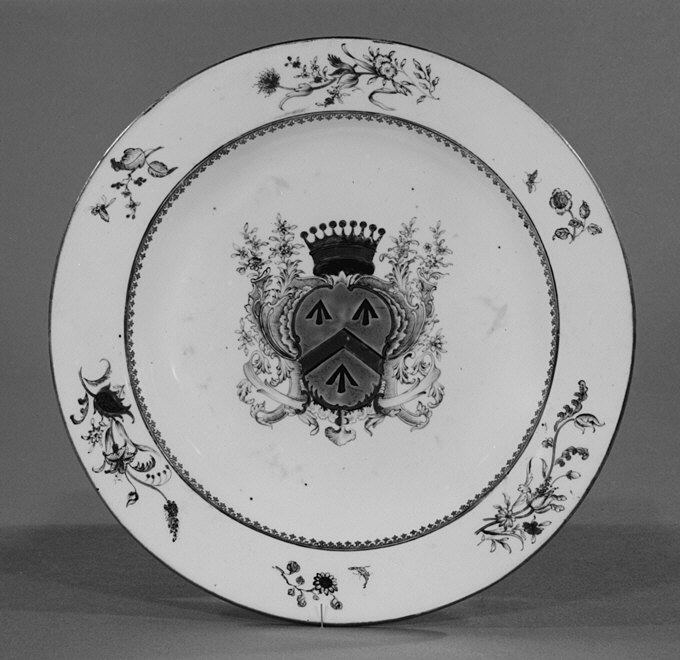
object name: plate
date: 1750-1760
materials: hard paste porcelain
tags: coat of arms